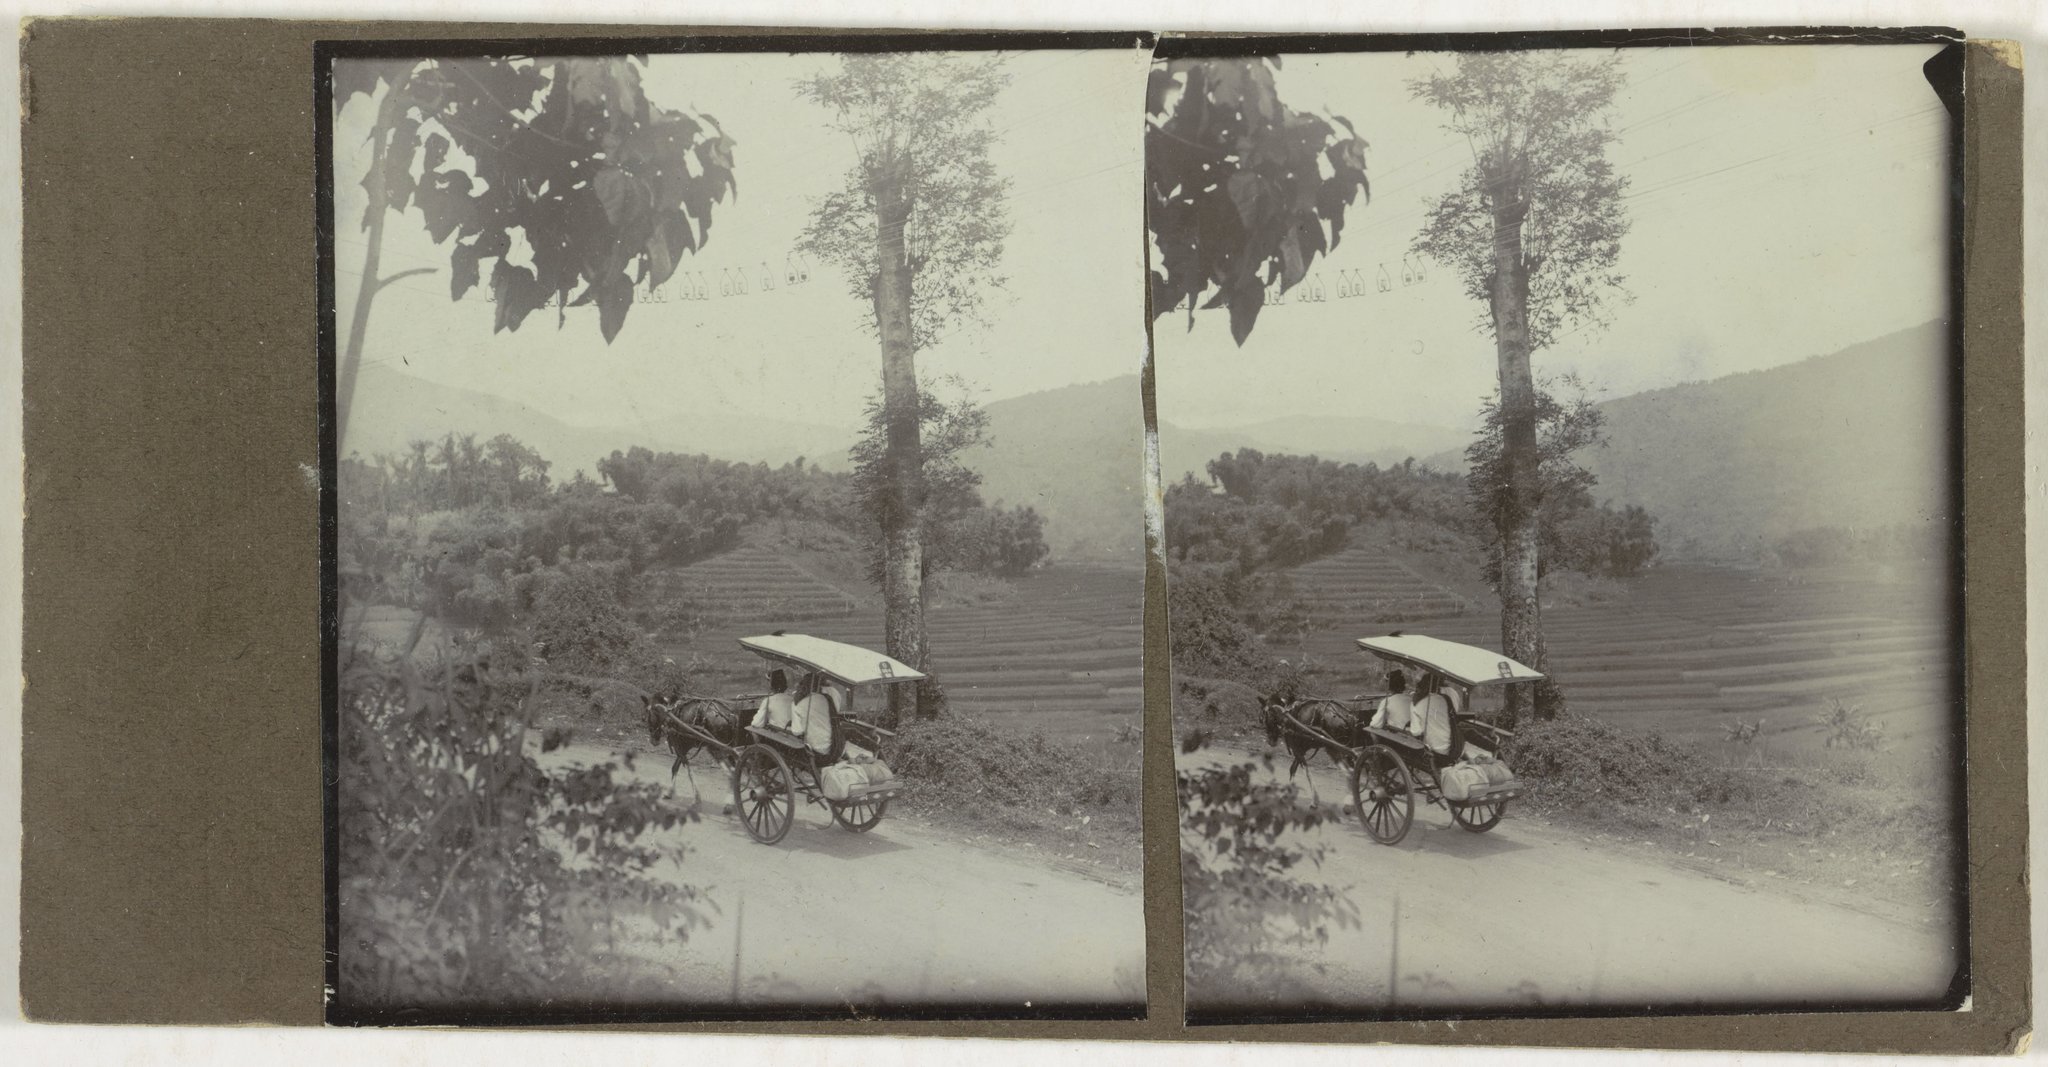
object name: stereograph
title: Weg naar Pengalengan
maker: Anonymous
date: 1900-1940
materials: paper, cardboard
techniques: gelatin silver print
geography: pangalengan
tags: road, path